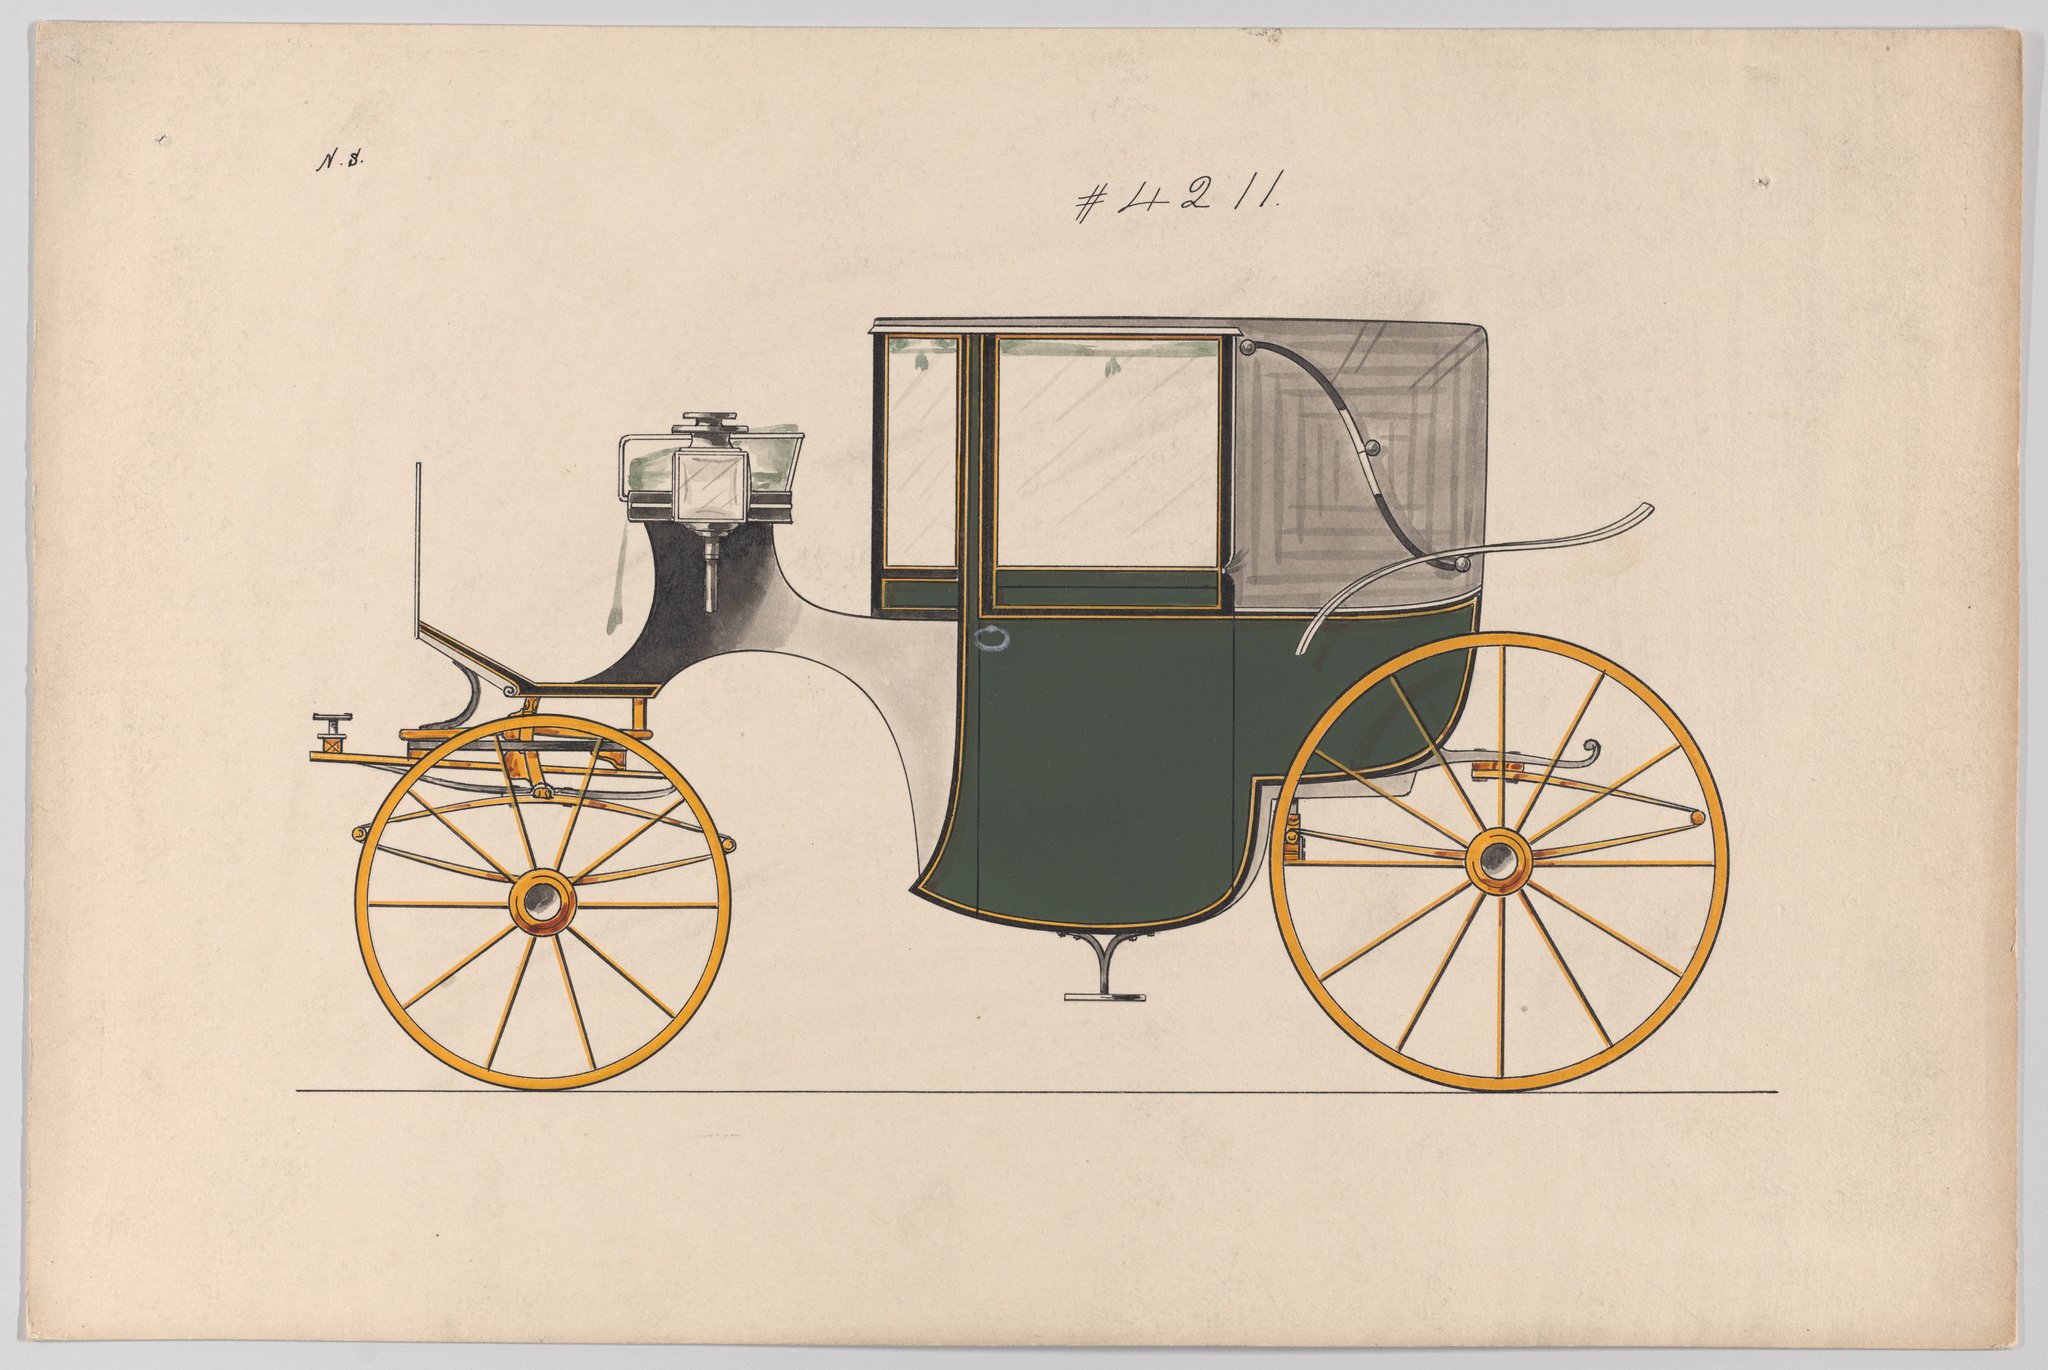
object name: drawing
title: Design for Landaulet, no. 4211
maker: brewster & co.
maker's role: manufacturer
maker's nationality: american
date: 1893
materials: gouache, ink, watercolor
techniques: pen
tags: carriages